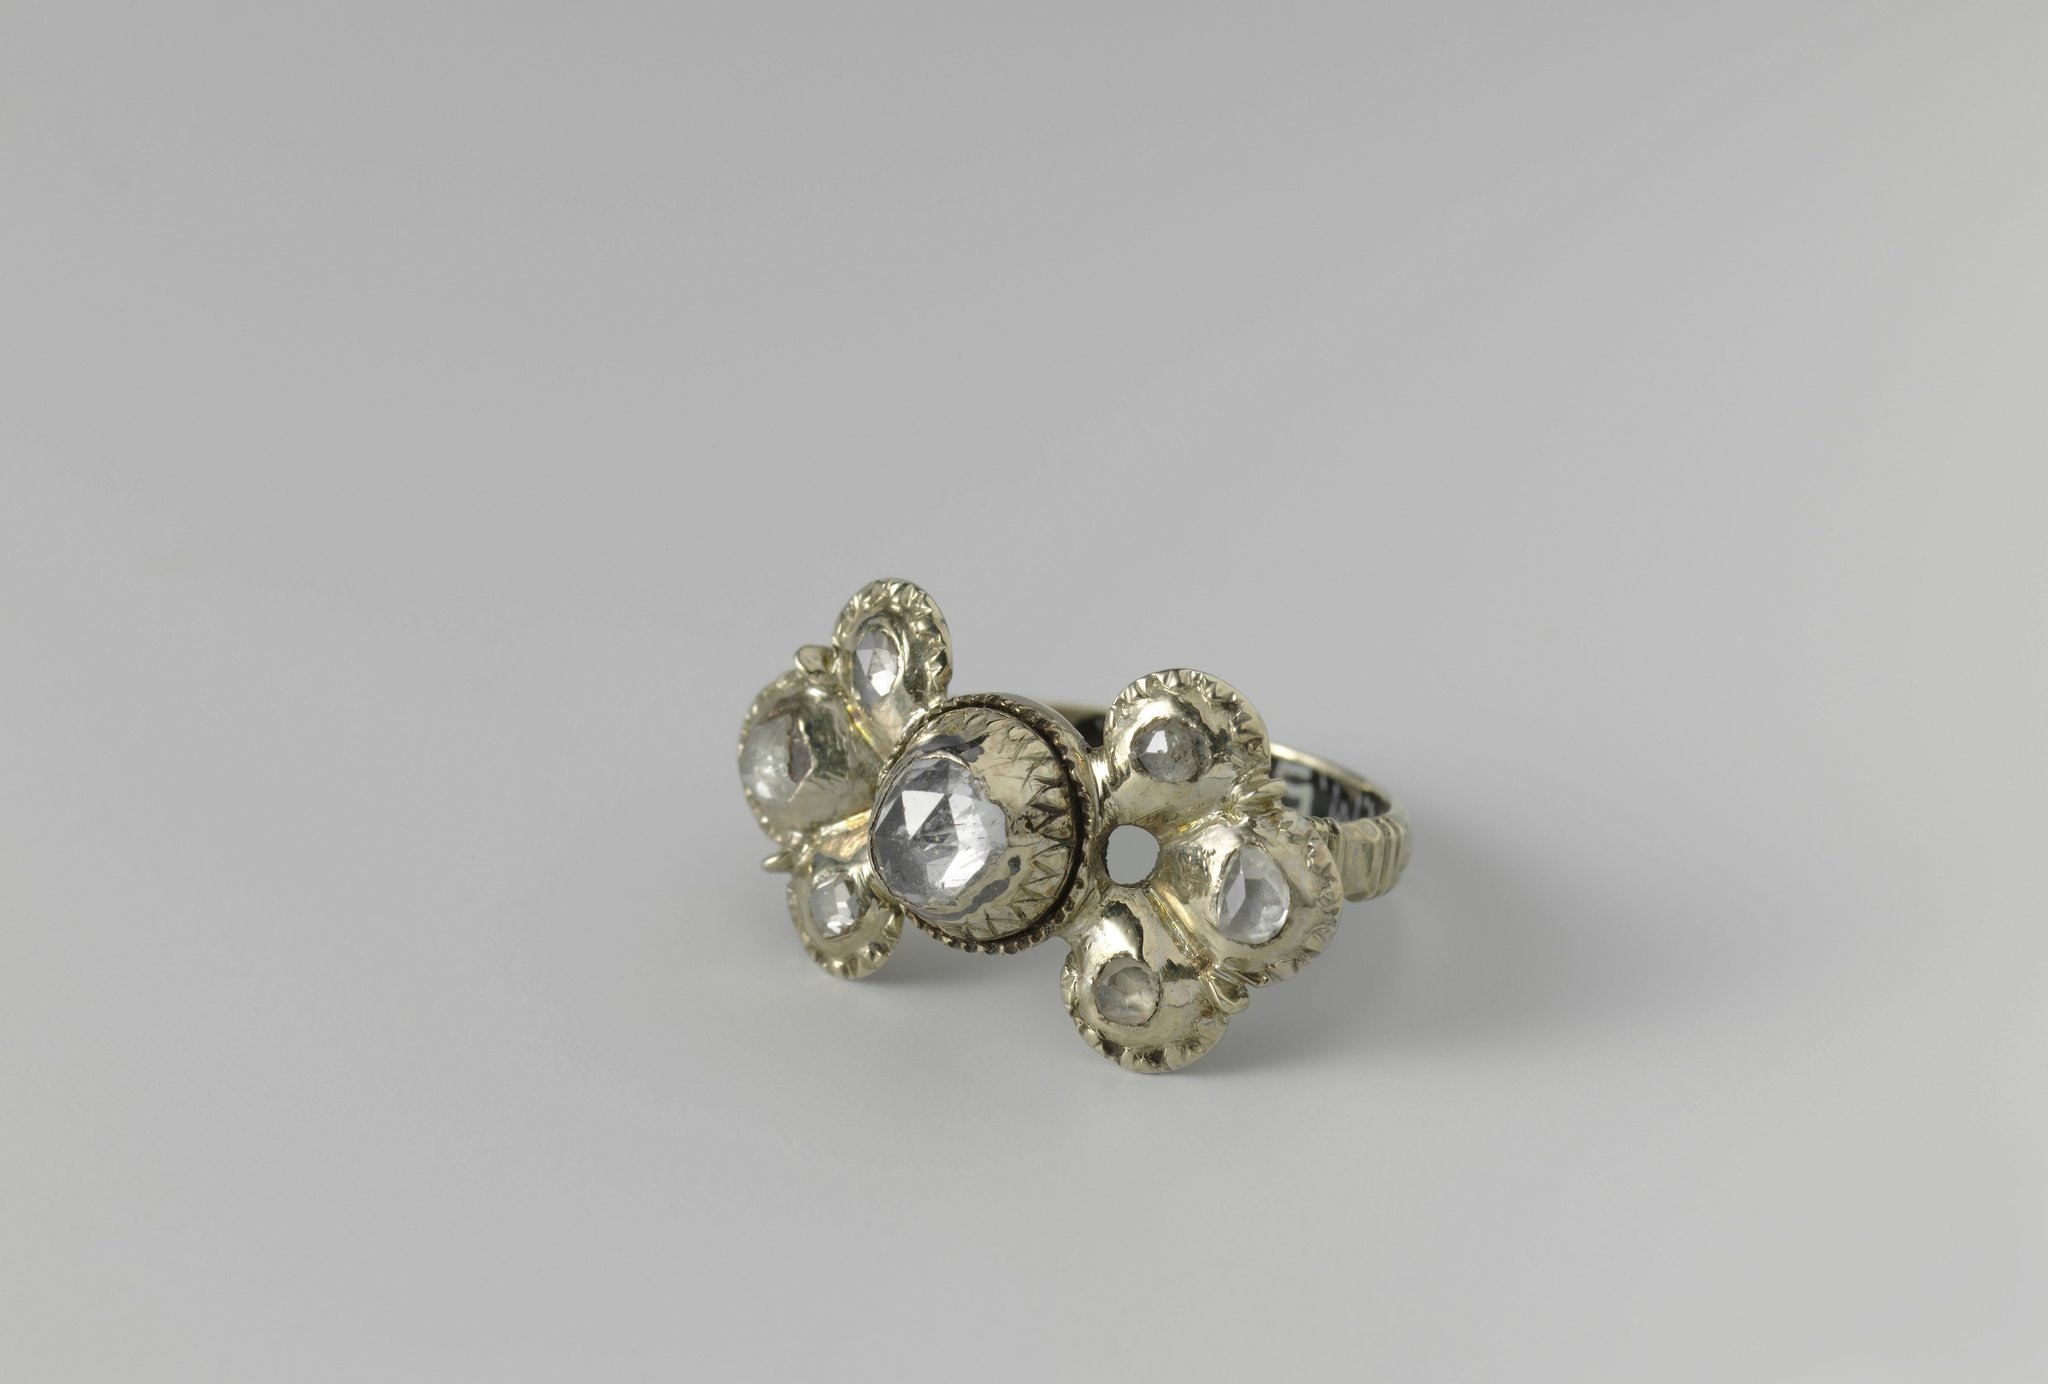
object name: jewellery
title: Ring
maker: Anonymous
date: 1650-1690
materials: diamond, gold, silver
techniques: gilding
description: Ring van verguld zilver met roosgeslepen diamanten. Het geheel in de vorm van een strik.